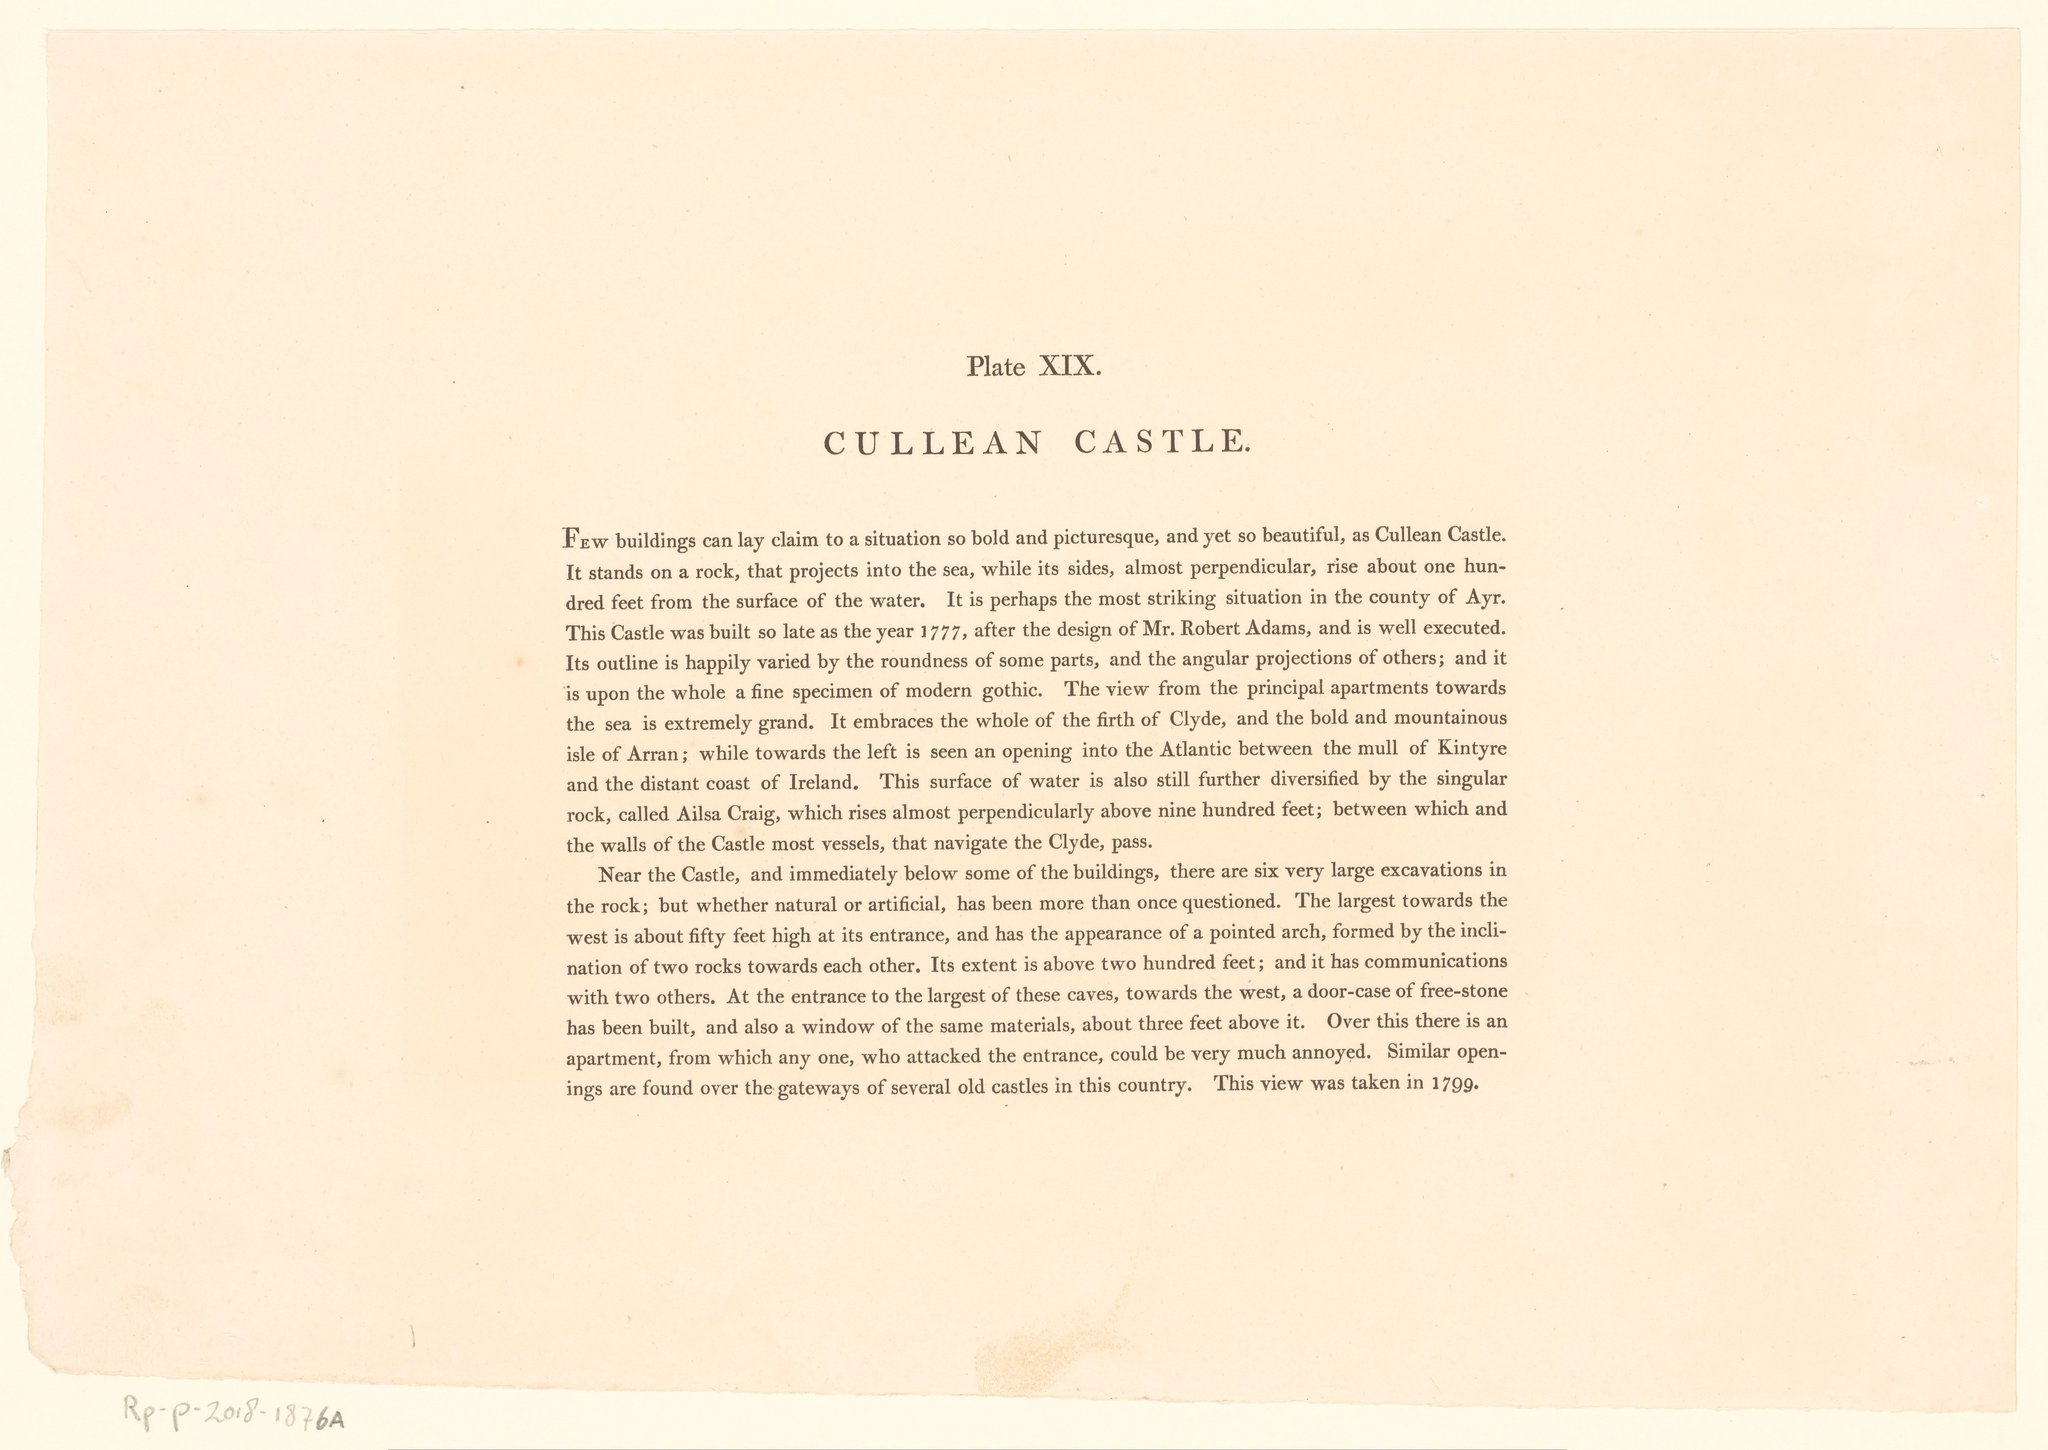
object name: text sheet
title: Plate XIX. Cullean Castle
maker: william miller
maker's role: bookseller, printer, publisher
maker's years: 1769-1844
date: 1801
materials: paper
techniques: letterpress printing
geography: london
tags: culzean castle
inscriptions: collector's mark: Lugt 2228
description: Tekstblad gebruikt in: Scotia Depicta; or the antiquities, castles, public buildings, noblemen (...). Londen: William Miller, 1801.